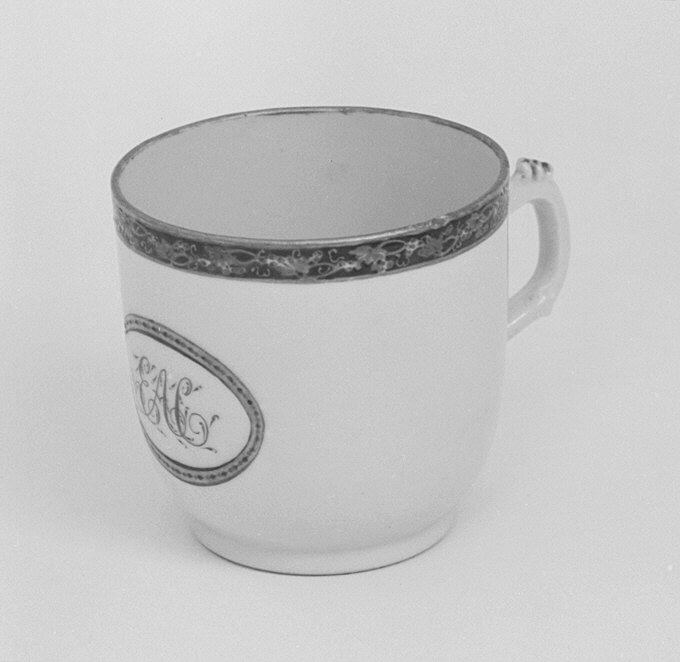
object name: coffee cup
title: Coffee cup (part of a service)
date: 1790-1800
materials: hard paste porcelain